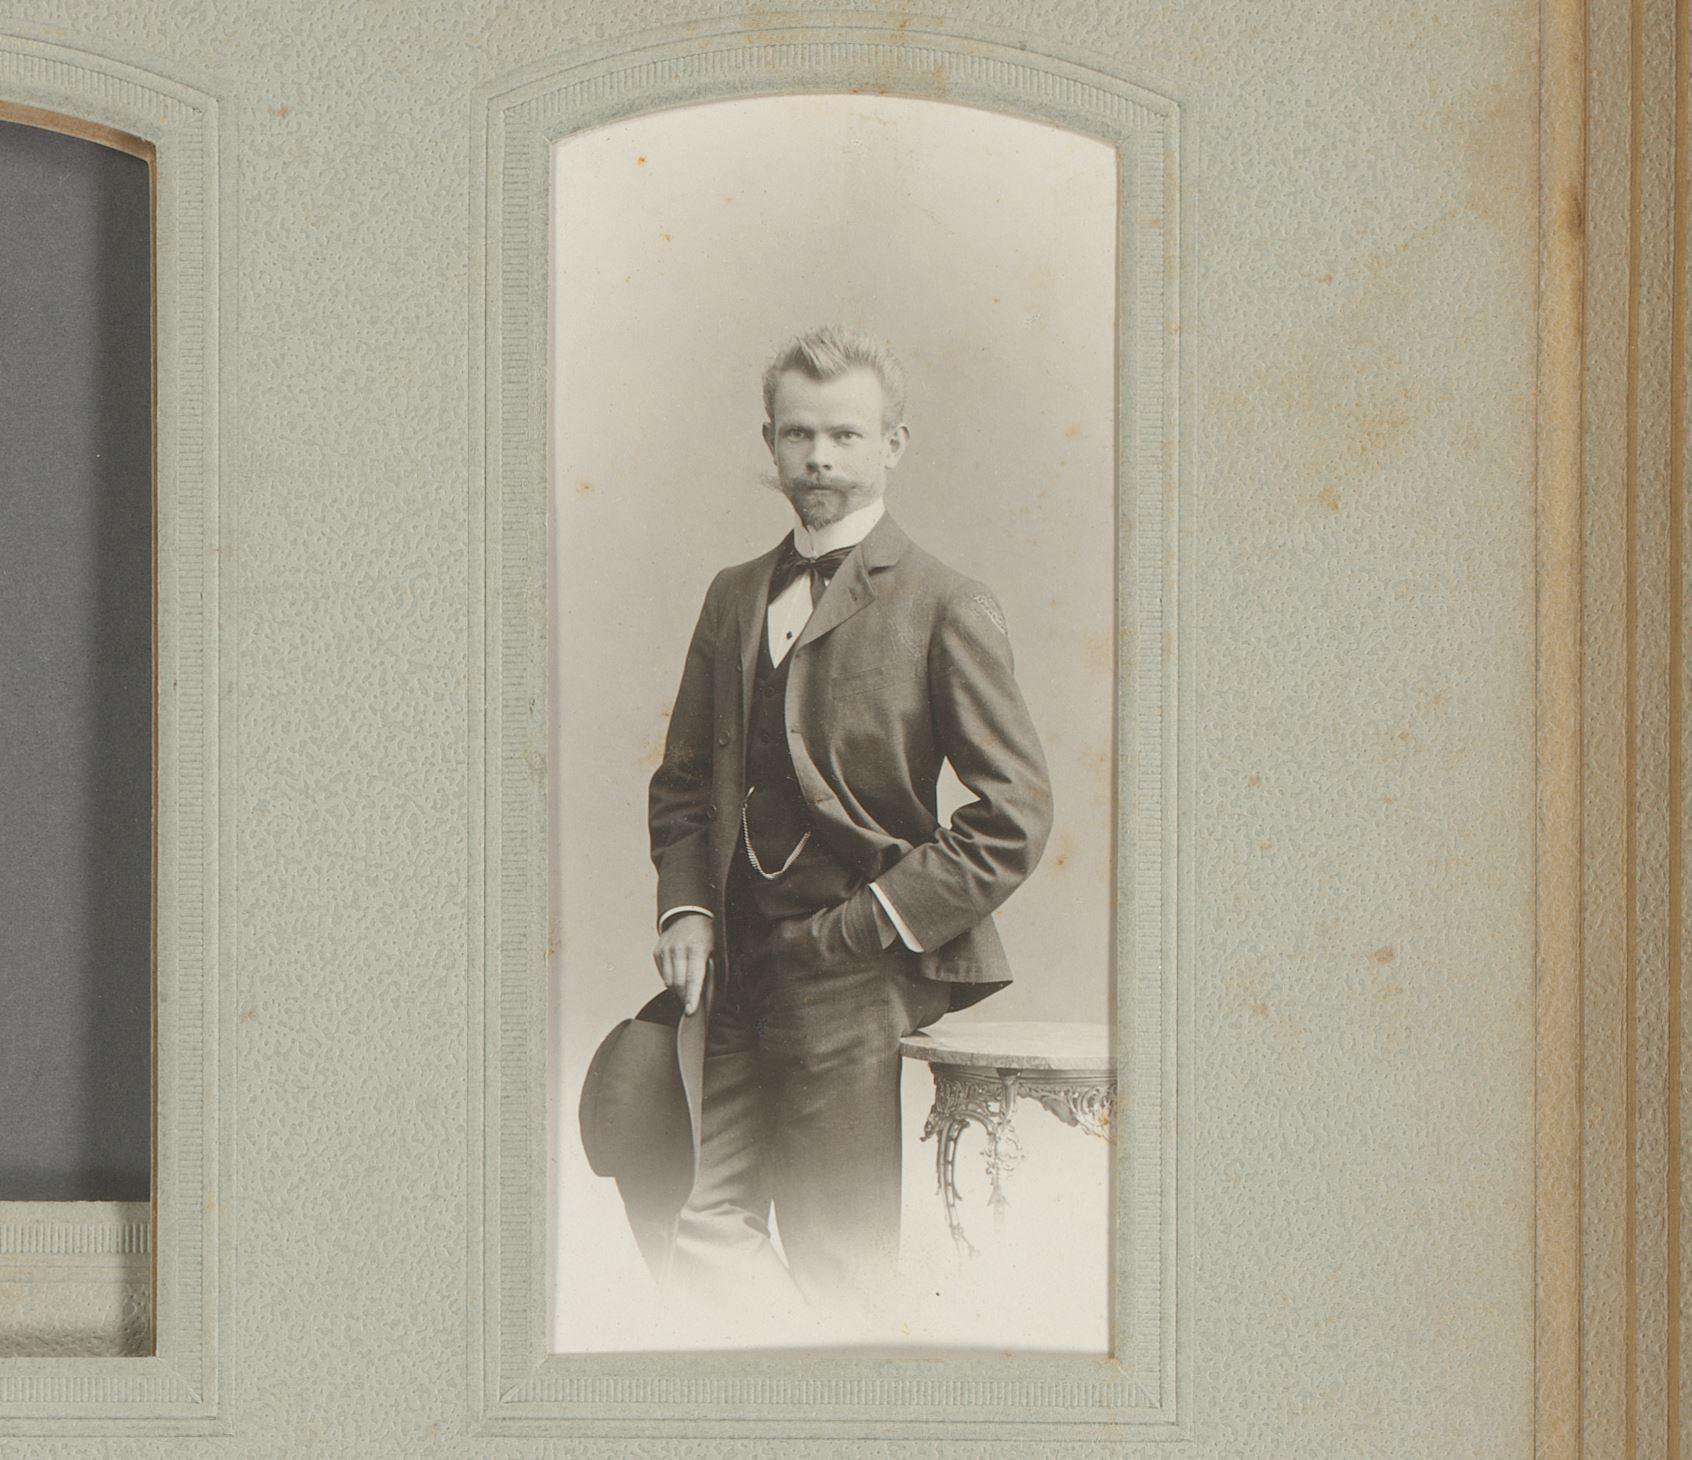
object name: album leaf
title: Portret van een onbekende man met snor en hoed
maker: Anonymous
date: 1890-1910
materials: paper, cardboard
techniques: gelatin silver print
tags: adult man, head-gear: hat, anonymous historical person portrayed